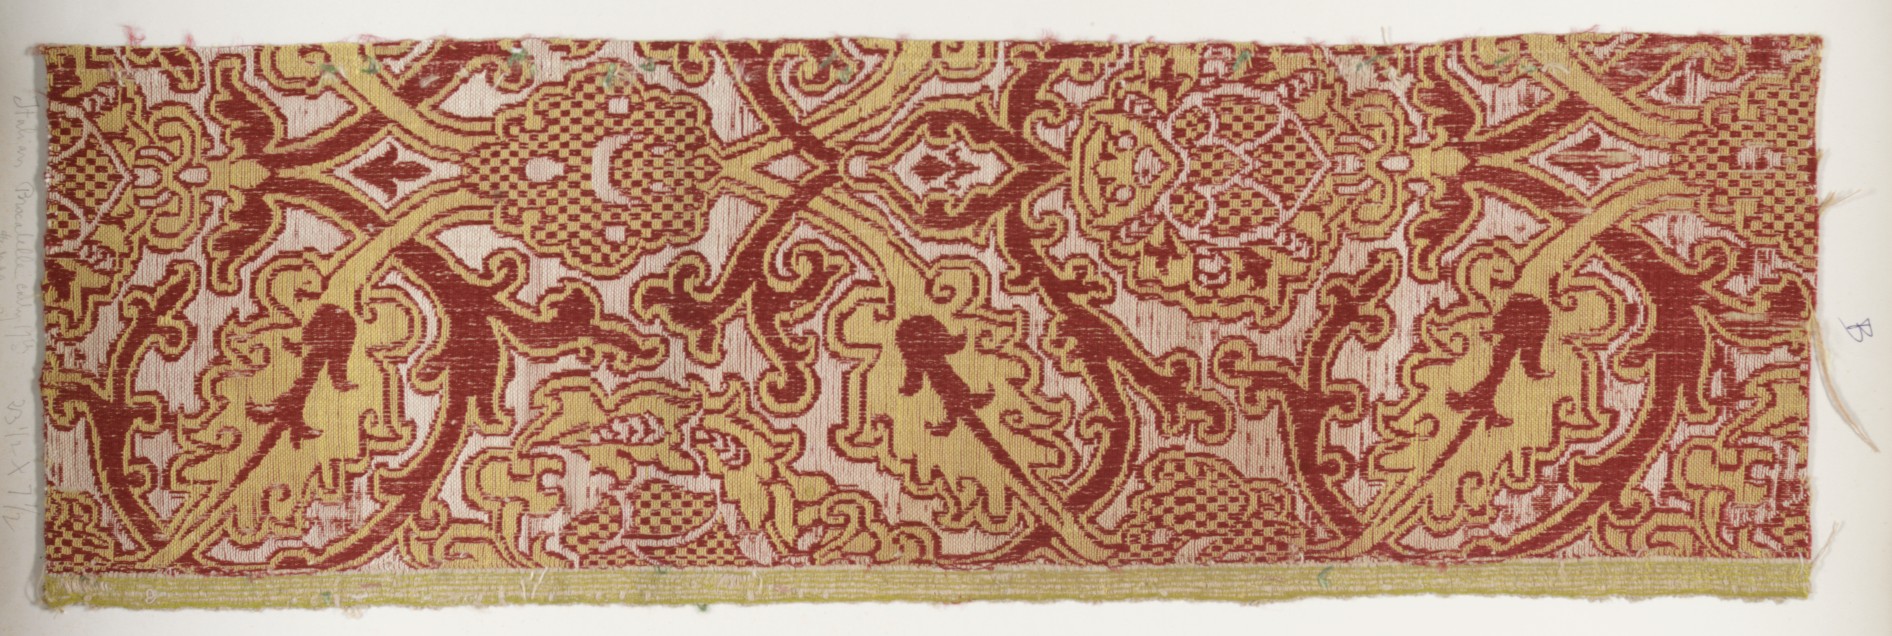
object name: fragment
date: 1601-1700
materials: silk